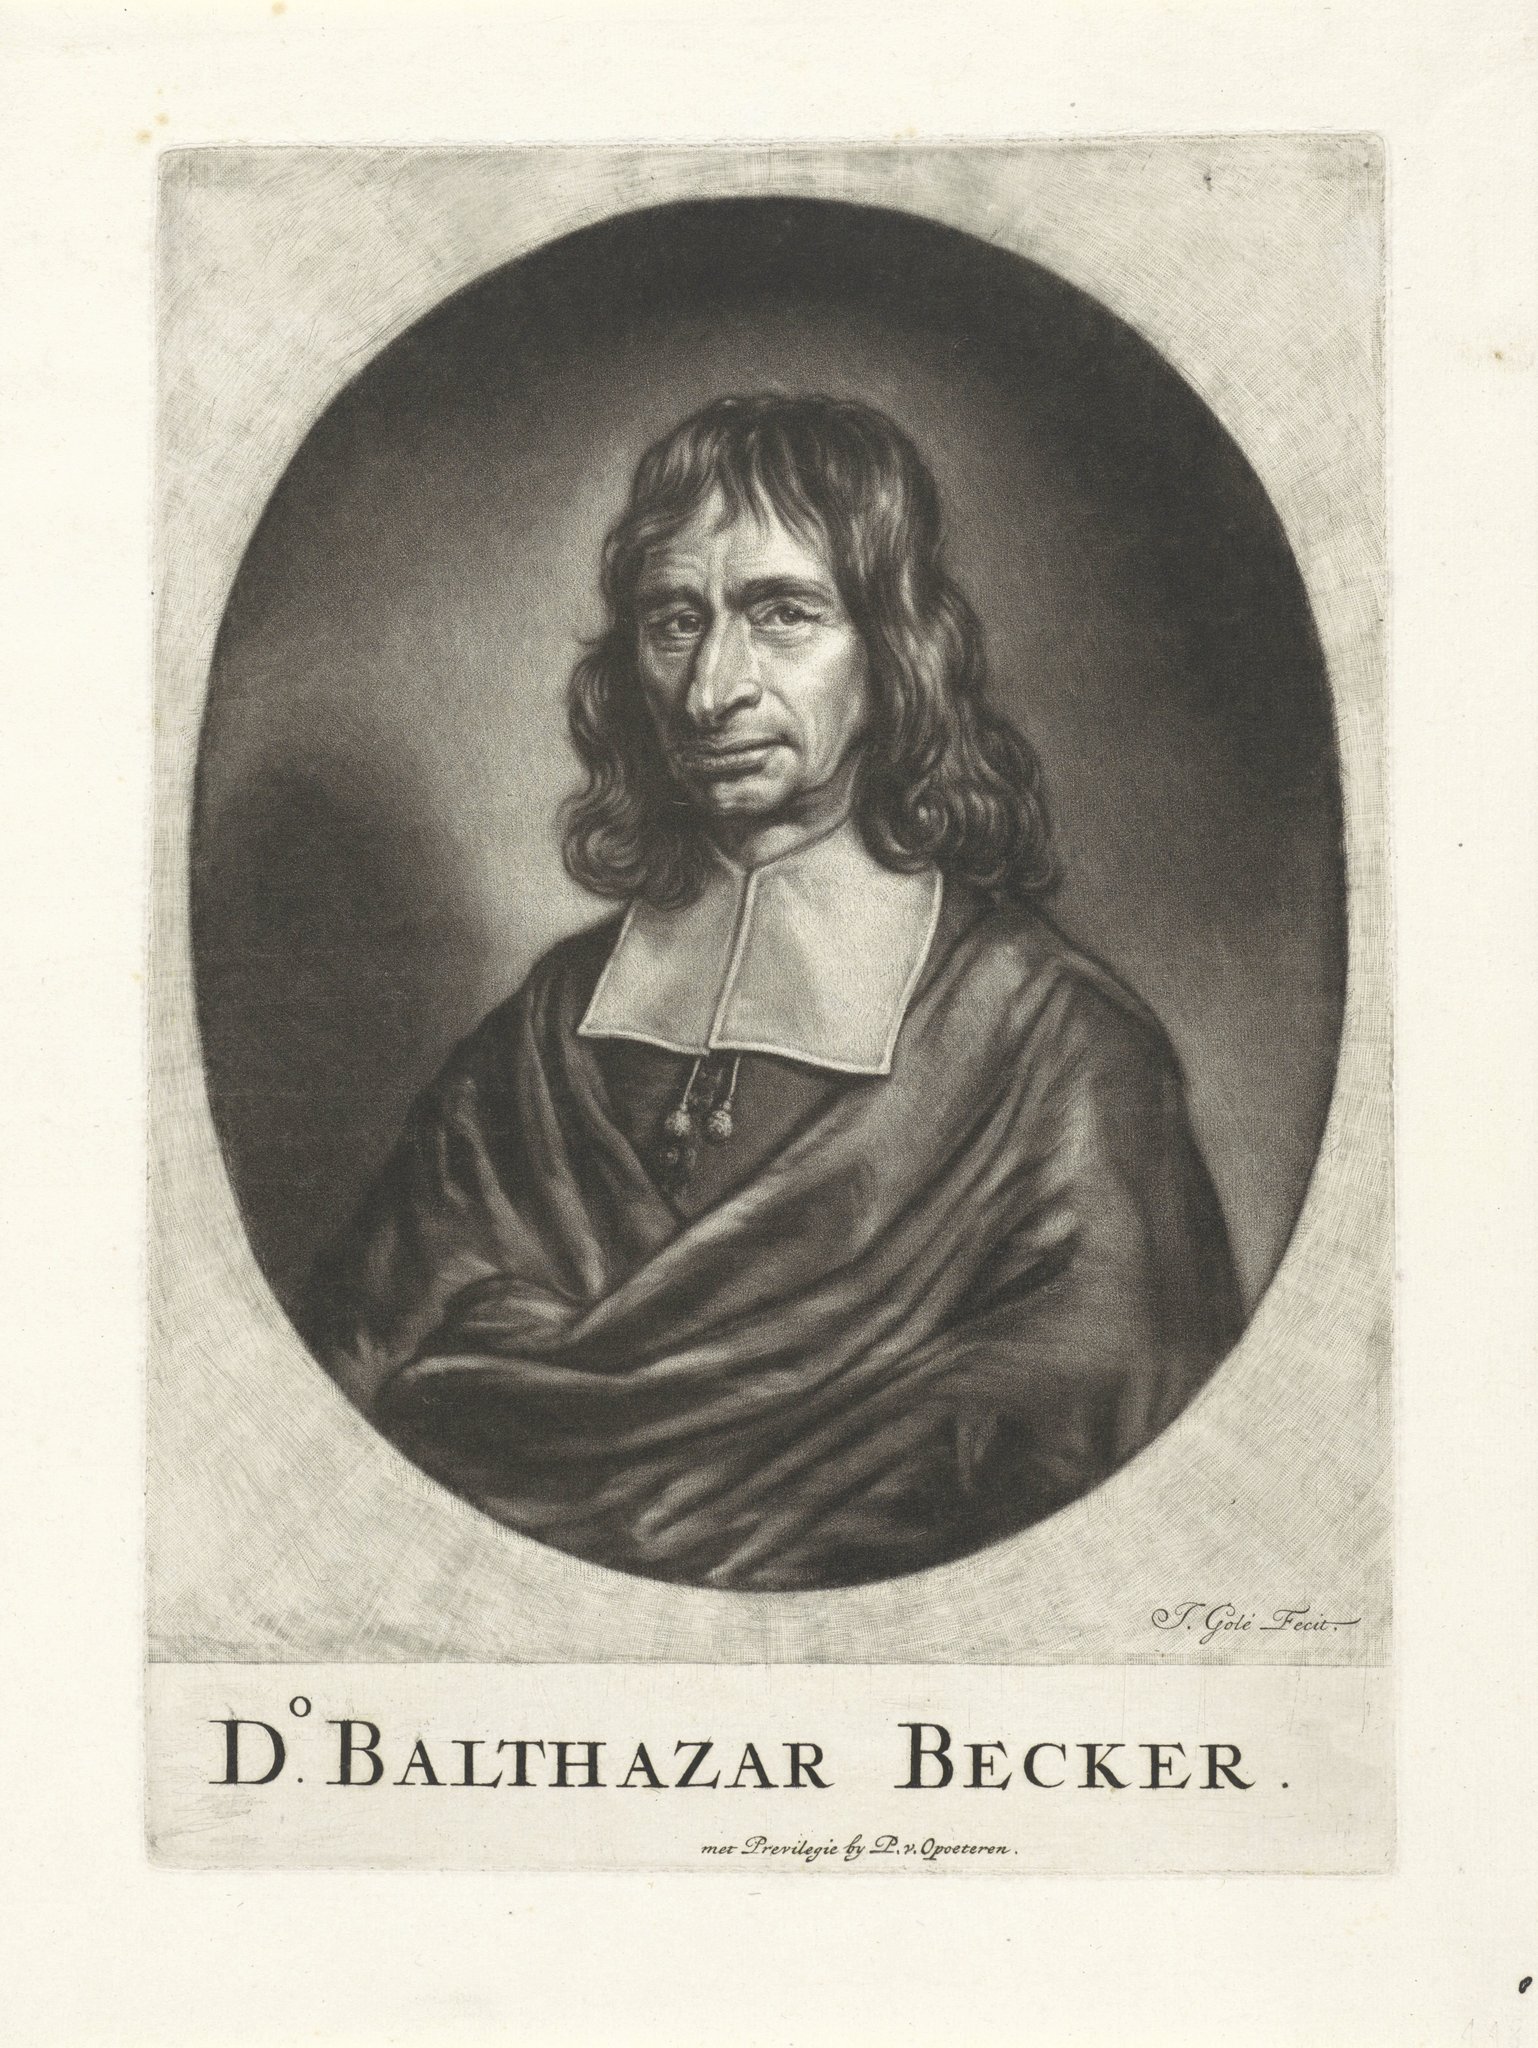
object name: print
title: Portret van Balthasar Bekker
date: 1670-1724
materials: paper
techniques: engraving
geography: amsterdam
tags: balthasar bekker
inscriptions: collector's mark: Lugt 240, signature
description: Balthasar Bekker, predikant en letterkundige te Amsterdam.